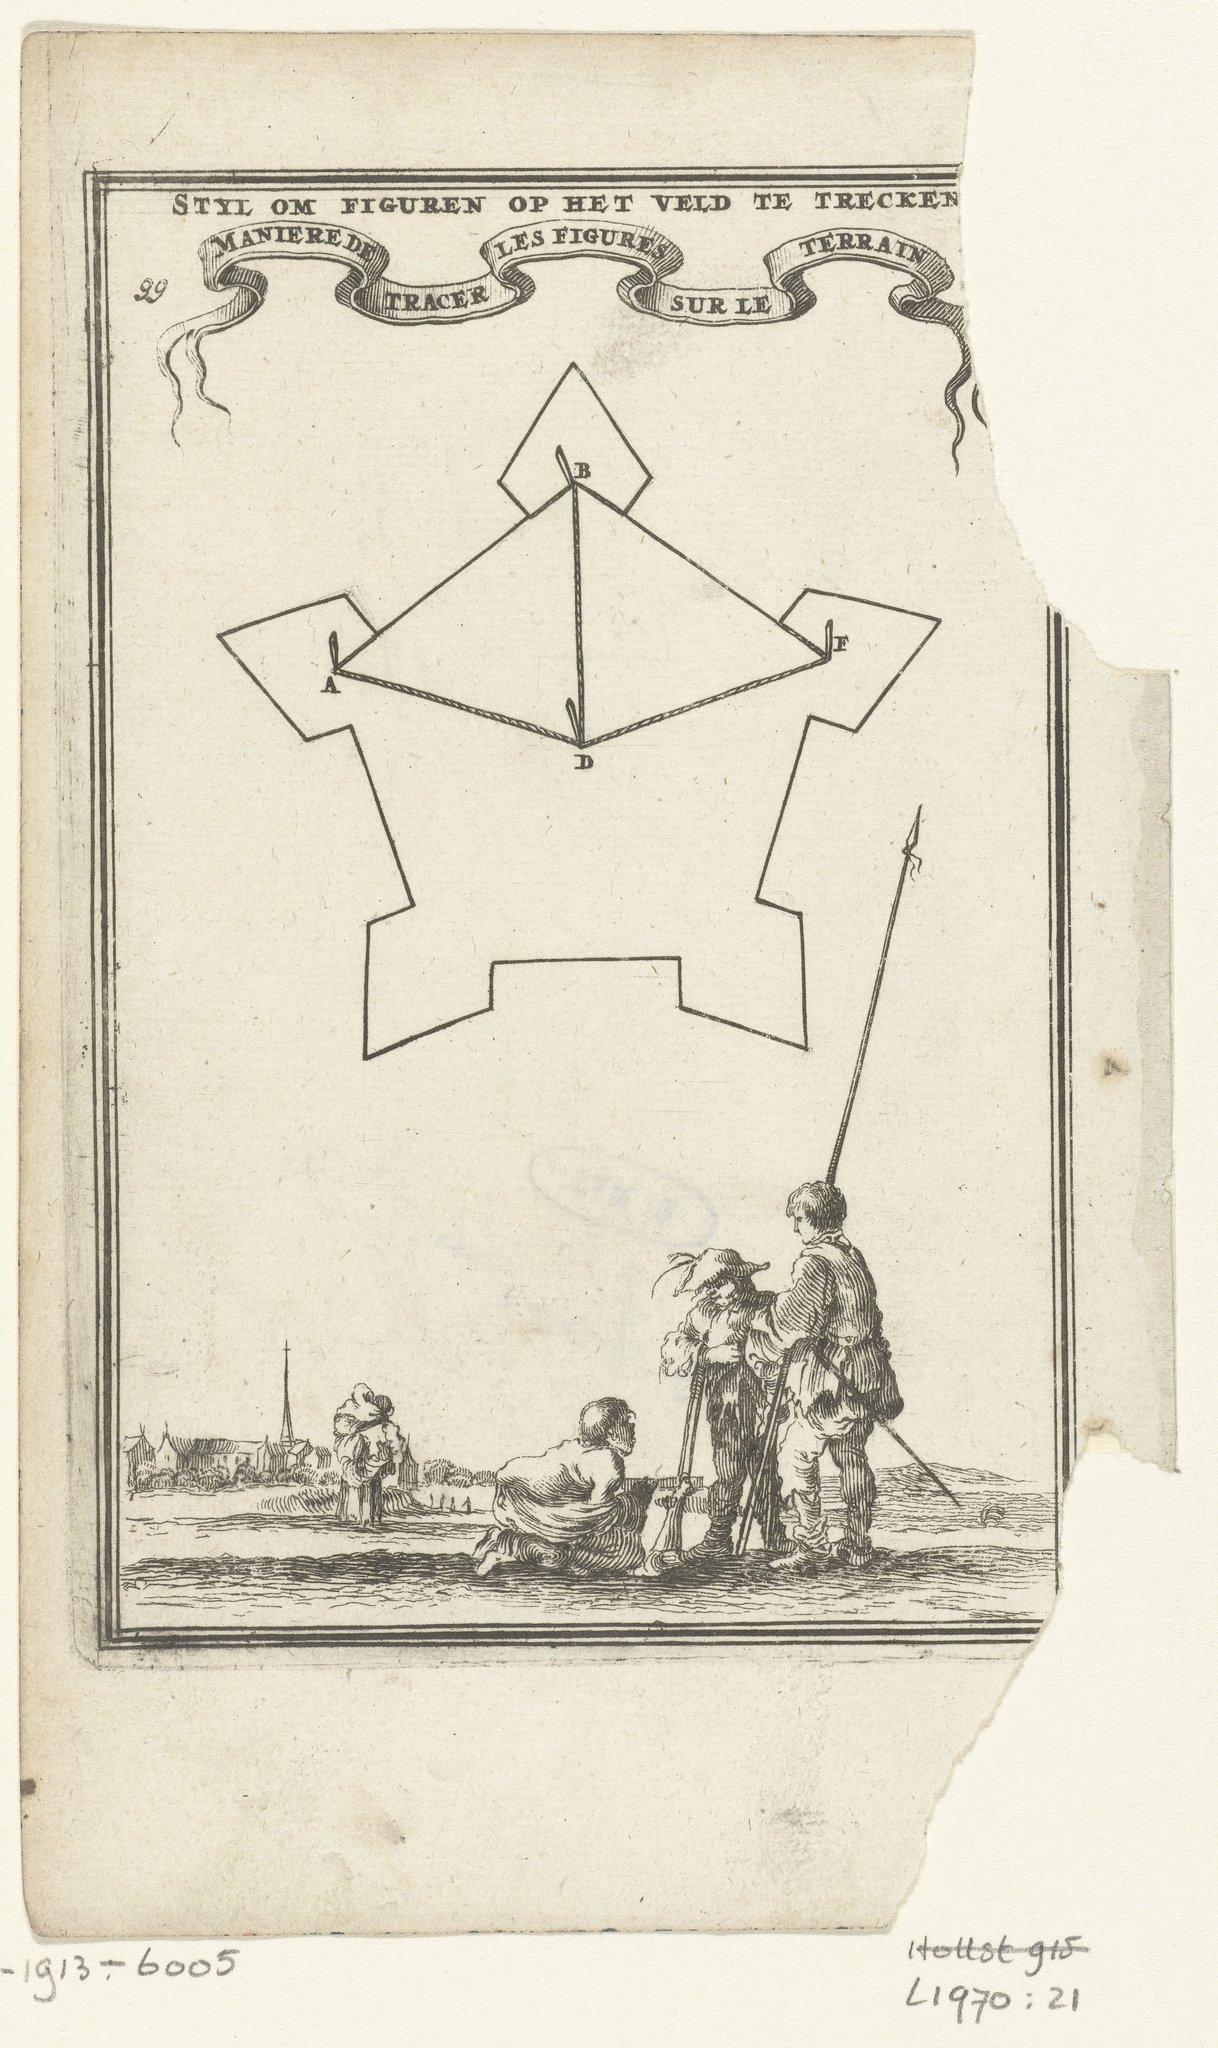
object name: book illustration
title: Illustratie voor 'Den Arbeid van Mars' van Allain Manesson Mallet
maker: romeyn de hooghe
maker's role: draughtsman, goldsmith, painter, print maker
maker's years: 1645-1708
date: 1672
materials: paper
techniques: etching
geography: amsterdam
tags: prospect of village, silhouette of village, fortifications, military engineering, soldiers and civilians, the soldier; the soldier's life, mathematics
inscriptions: collector's mark: Lugt 2228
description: Grondplan voor een vesting, fort of versterking (vijfhoek). Daaronder een man geknield voor twee soldaten. In de hoek linksboven het cijfer 99 (= het nummer van de pagina in het boek waartegenover de illustratie geplaatst is).